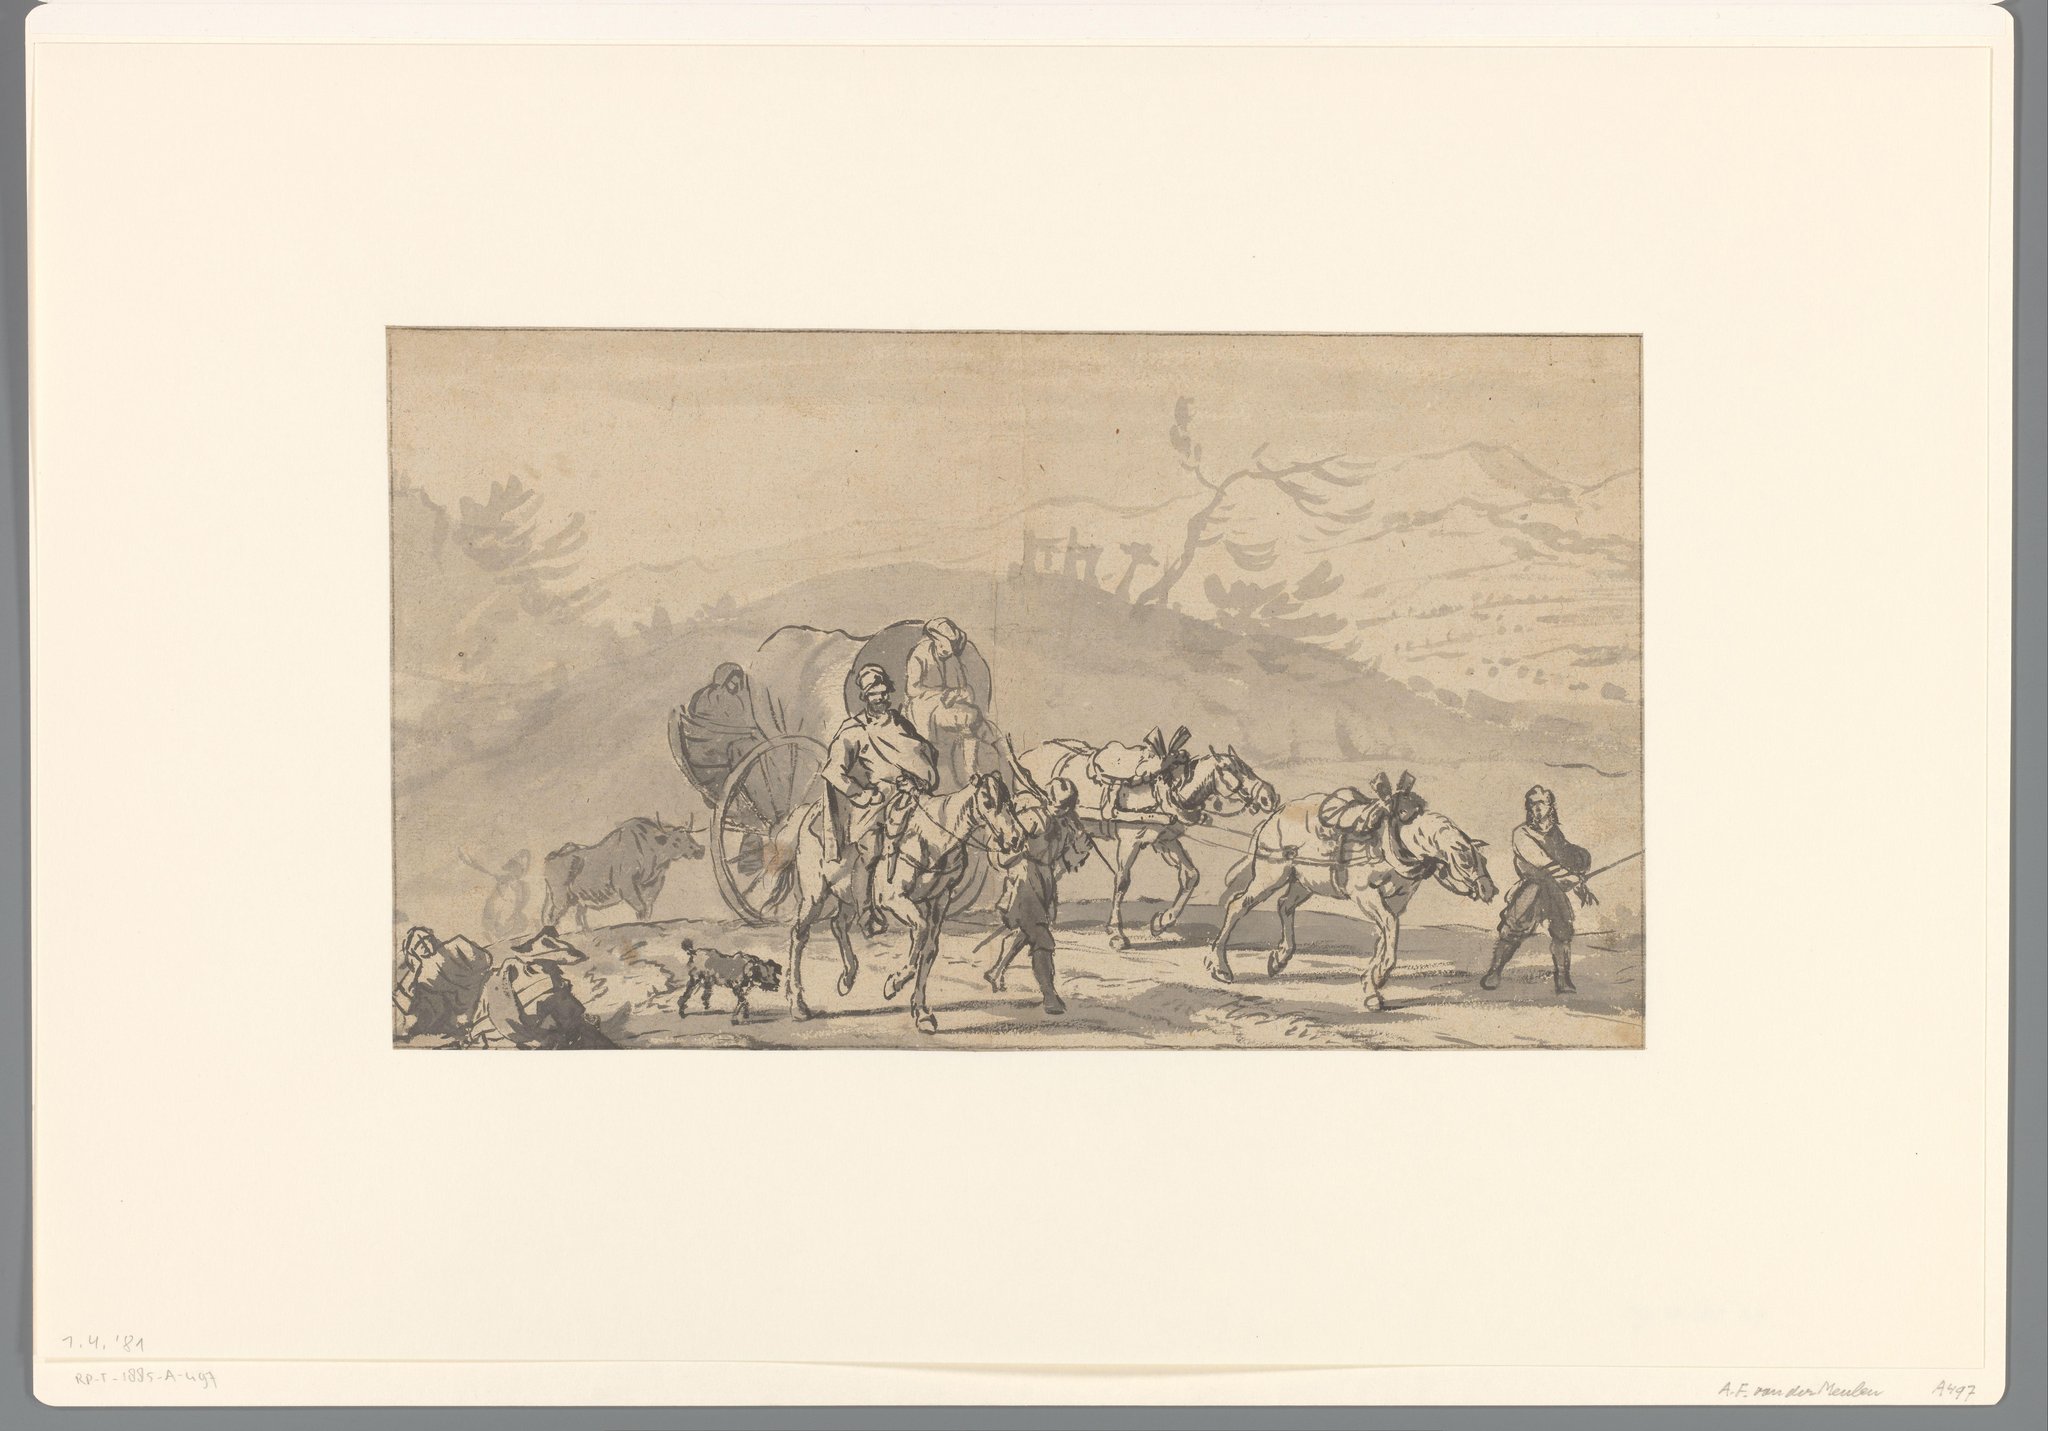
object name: drawing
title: Een met twee paarden bespannen kar in een landschap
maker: adam frans van der meulen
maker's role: draughtsman, painter, publisher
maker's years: 1632-1690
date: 1642-1690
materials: paper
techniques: brush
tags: two-wheeled vehicle drawn by two animals